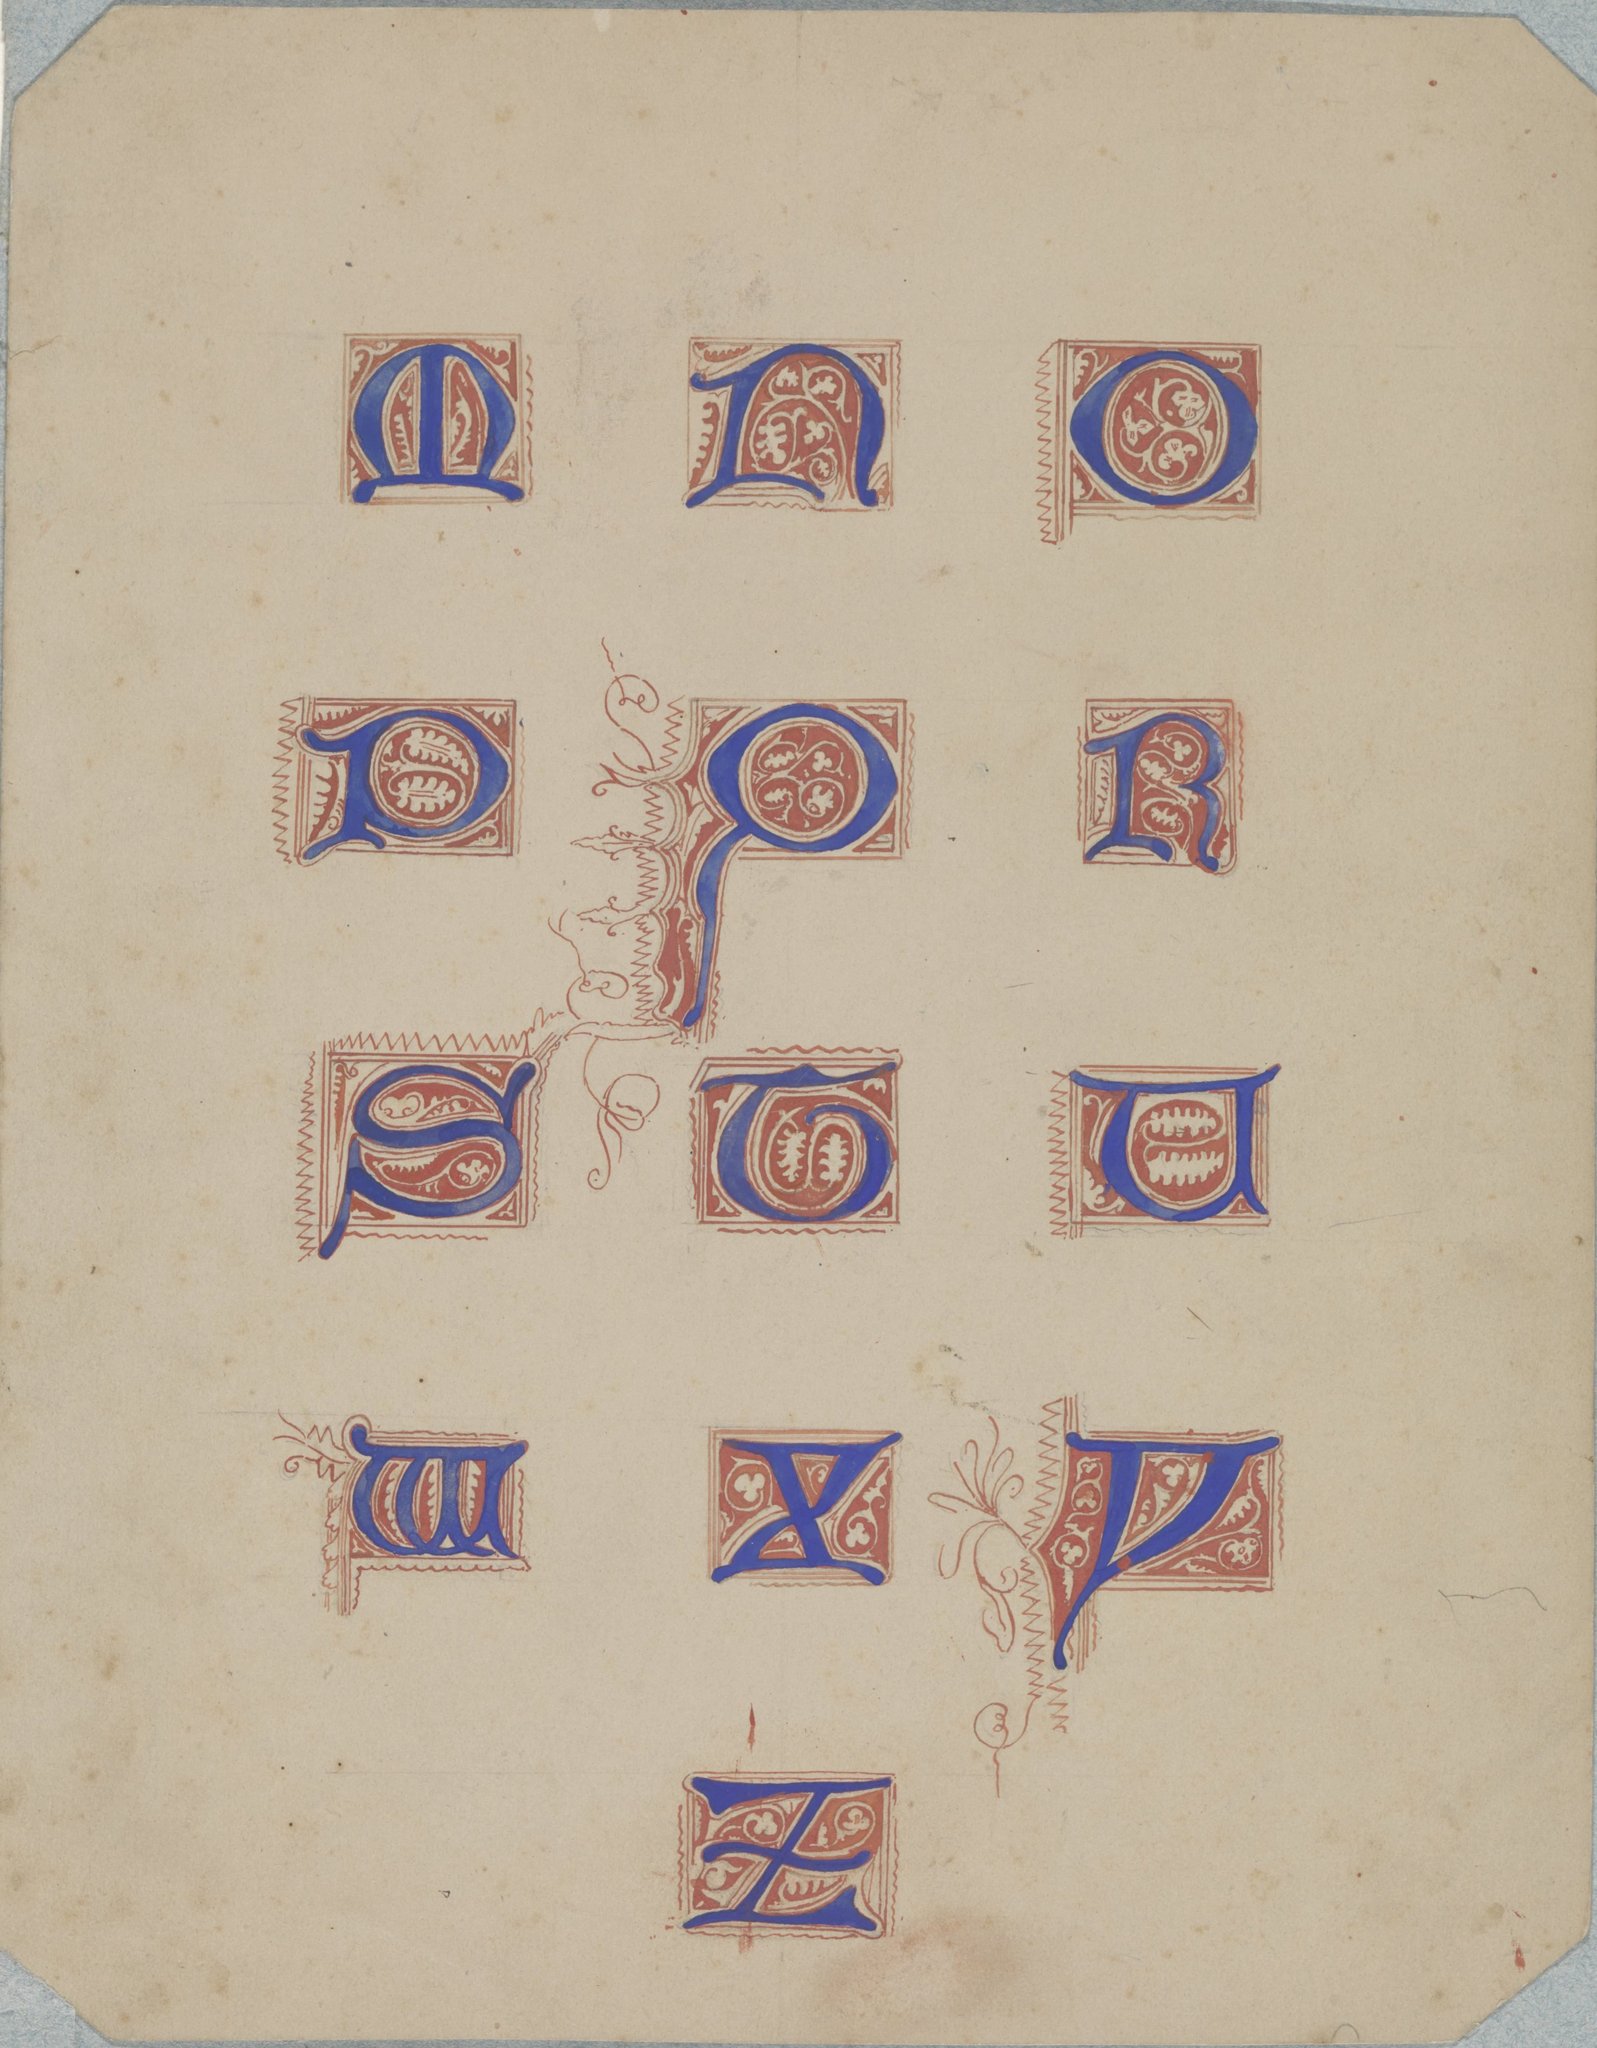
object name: design drawing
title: The Letters M through Z in Gothic Style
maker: henri cameré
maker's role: designer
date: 1864-1894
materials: ink, paper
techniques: pen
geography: paris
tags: initial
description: In designing these letters, Cameré was influenced by the initials in late medieval manuscripts. They were popular motifs in jewellery to signify the names of children and loved ones. A bracelet by the French goldsmith Lucien Falize with nearly the same initials is in the Schmuckmuseum in Pforzheim, Germany.